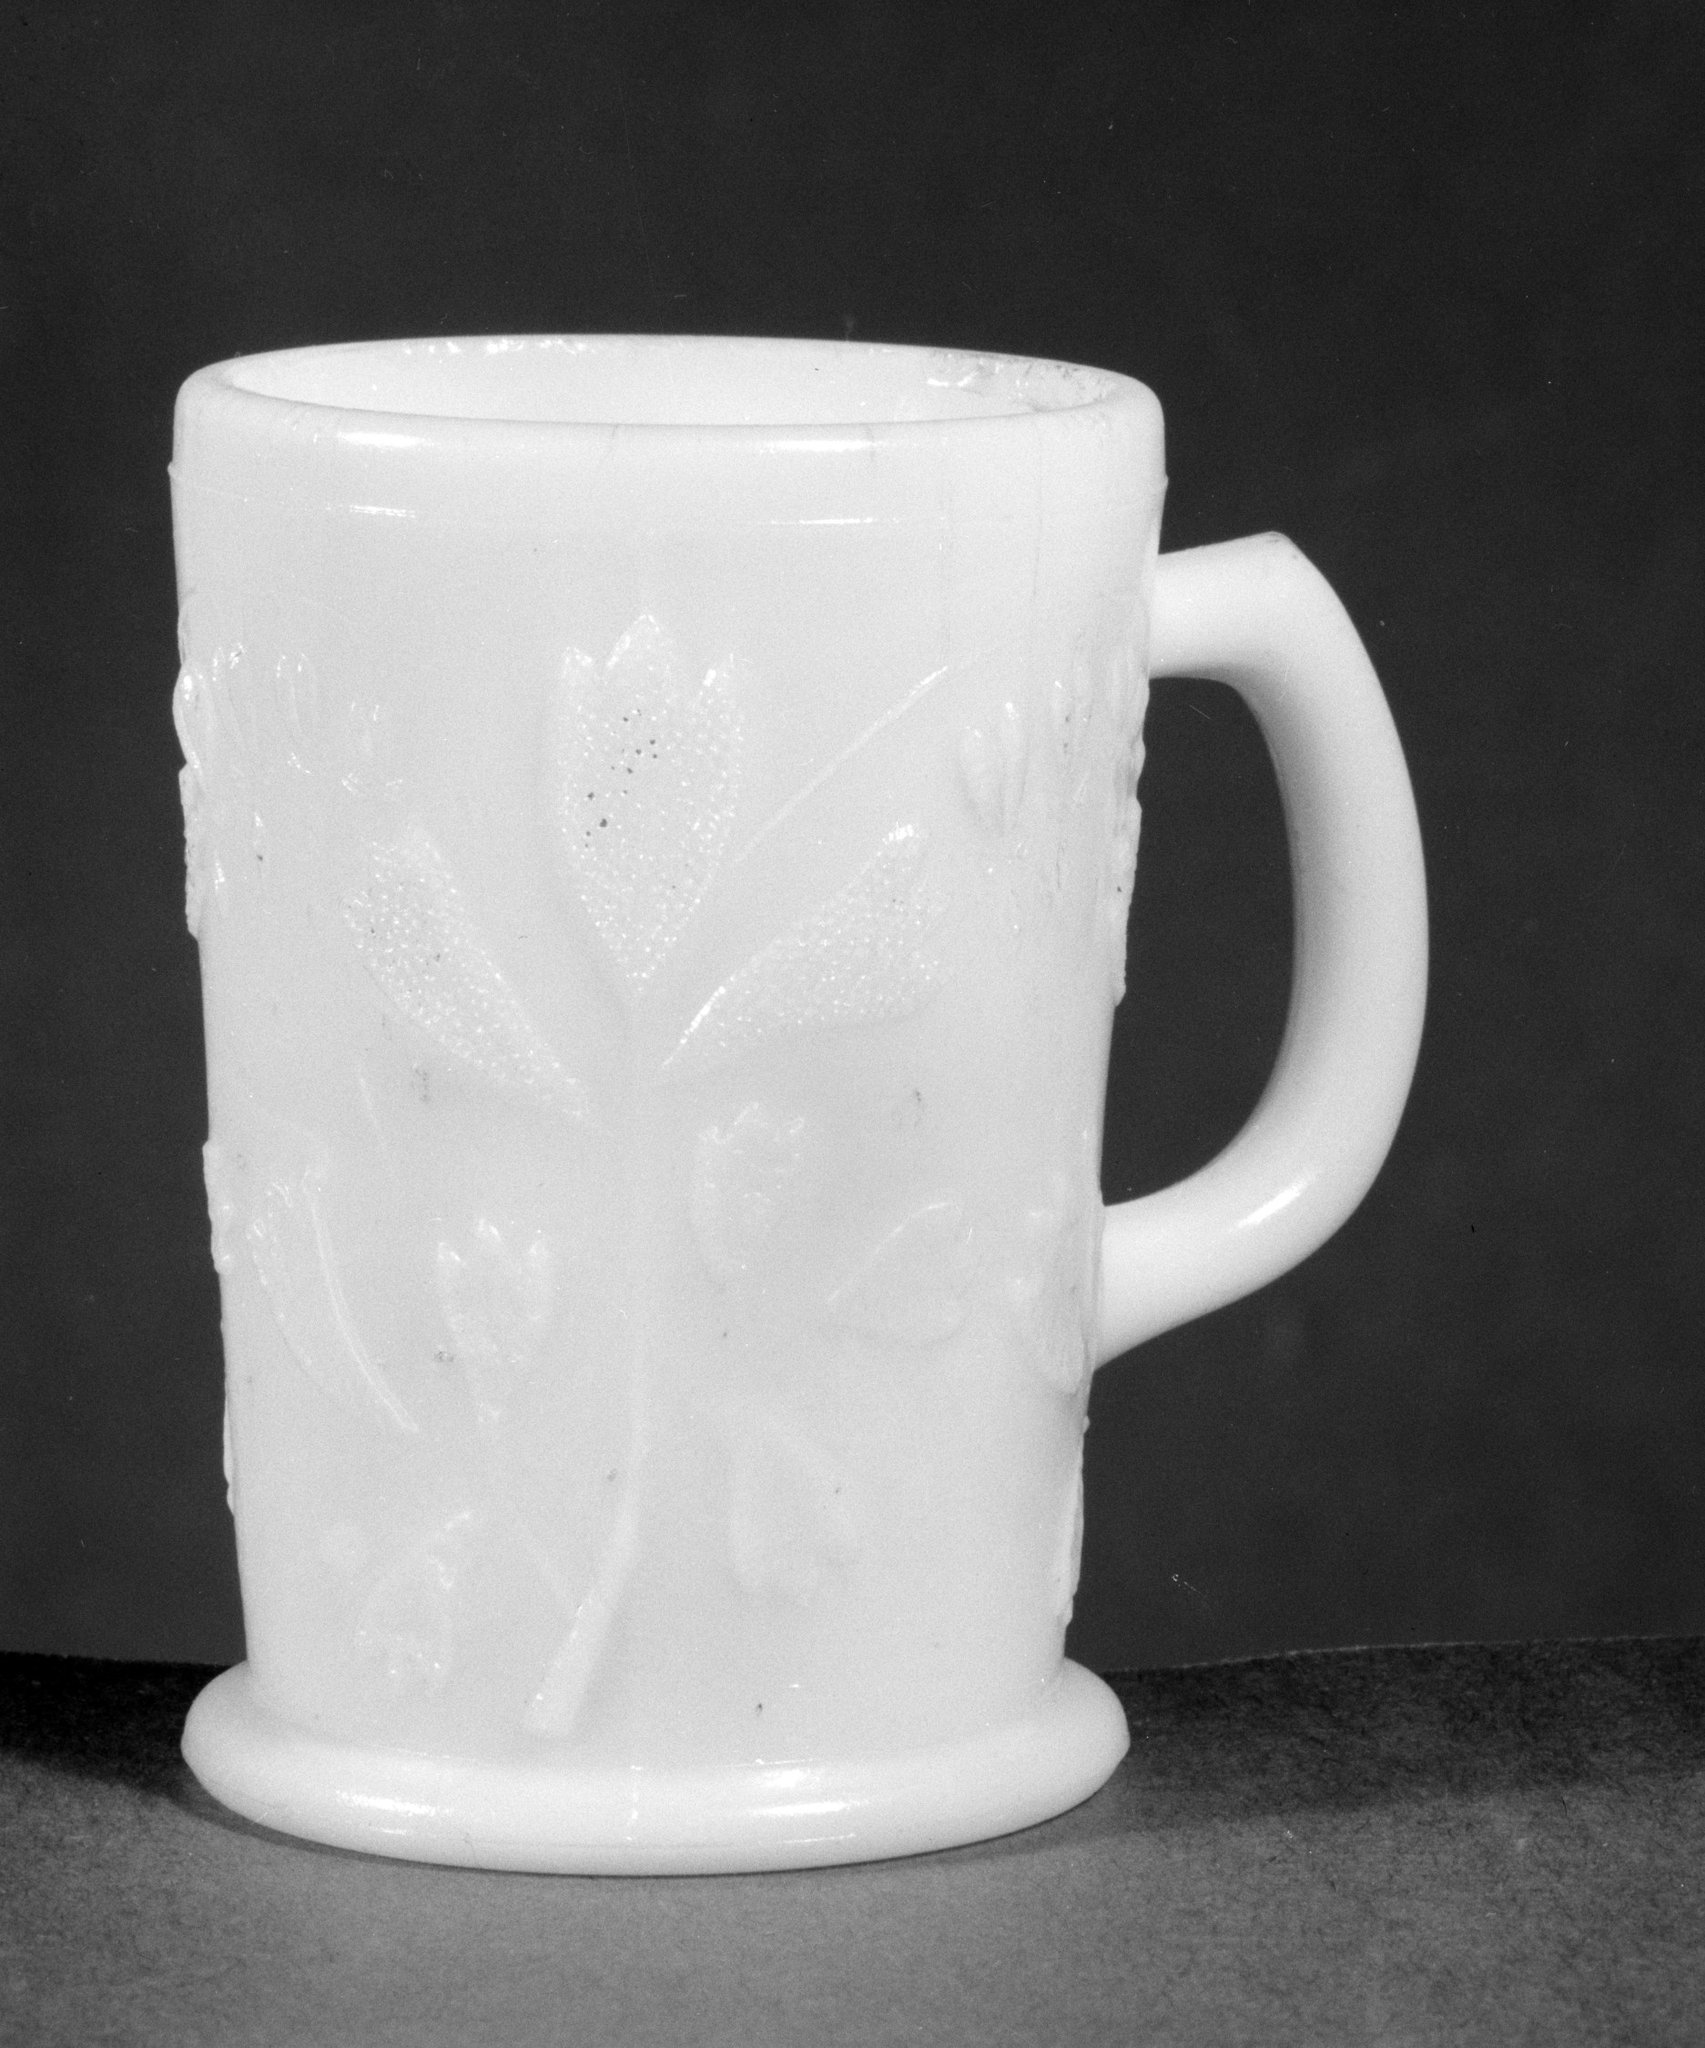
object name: mug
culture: american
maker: king glass company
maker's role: maker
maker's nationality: american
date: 1885-1895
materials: glass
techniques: pressed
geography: united states